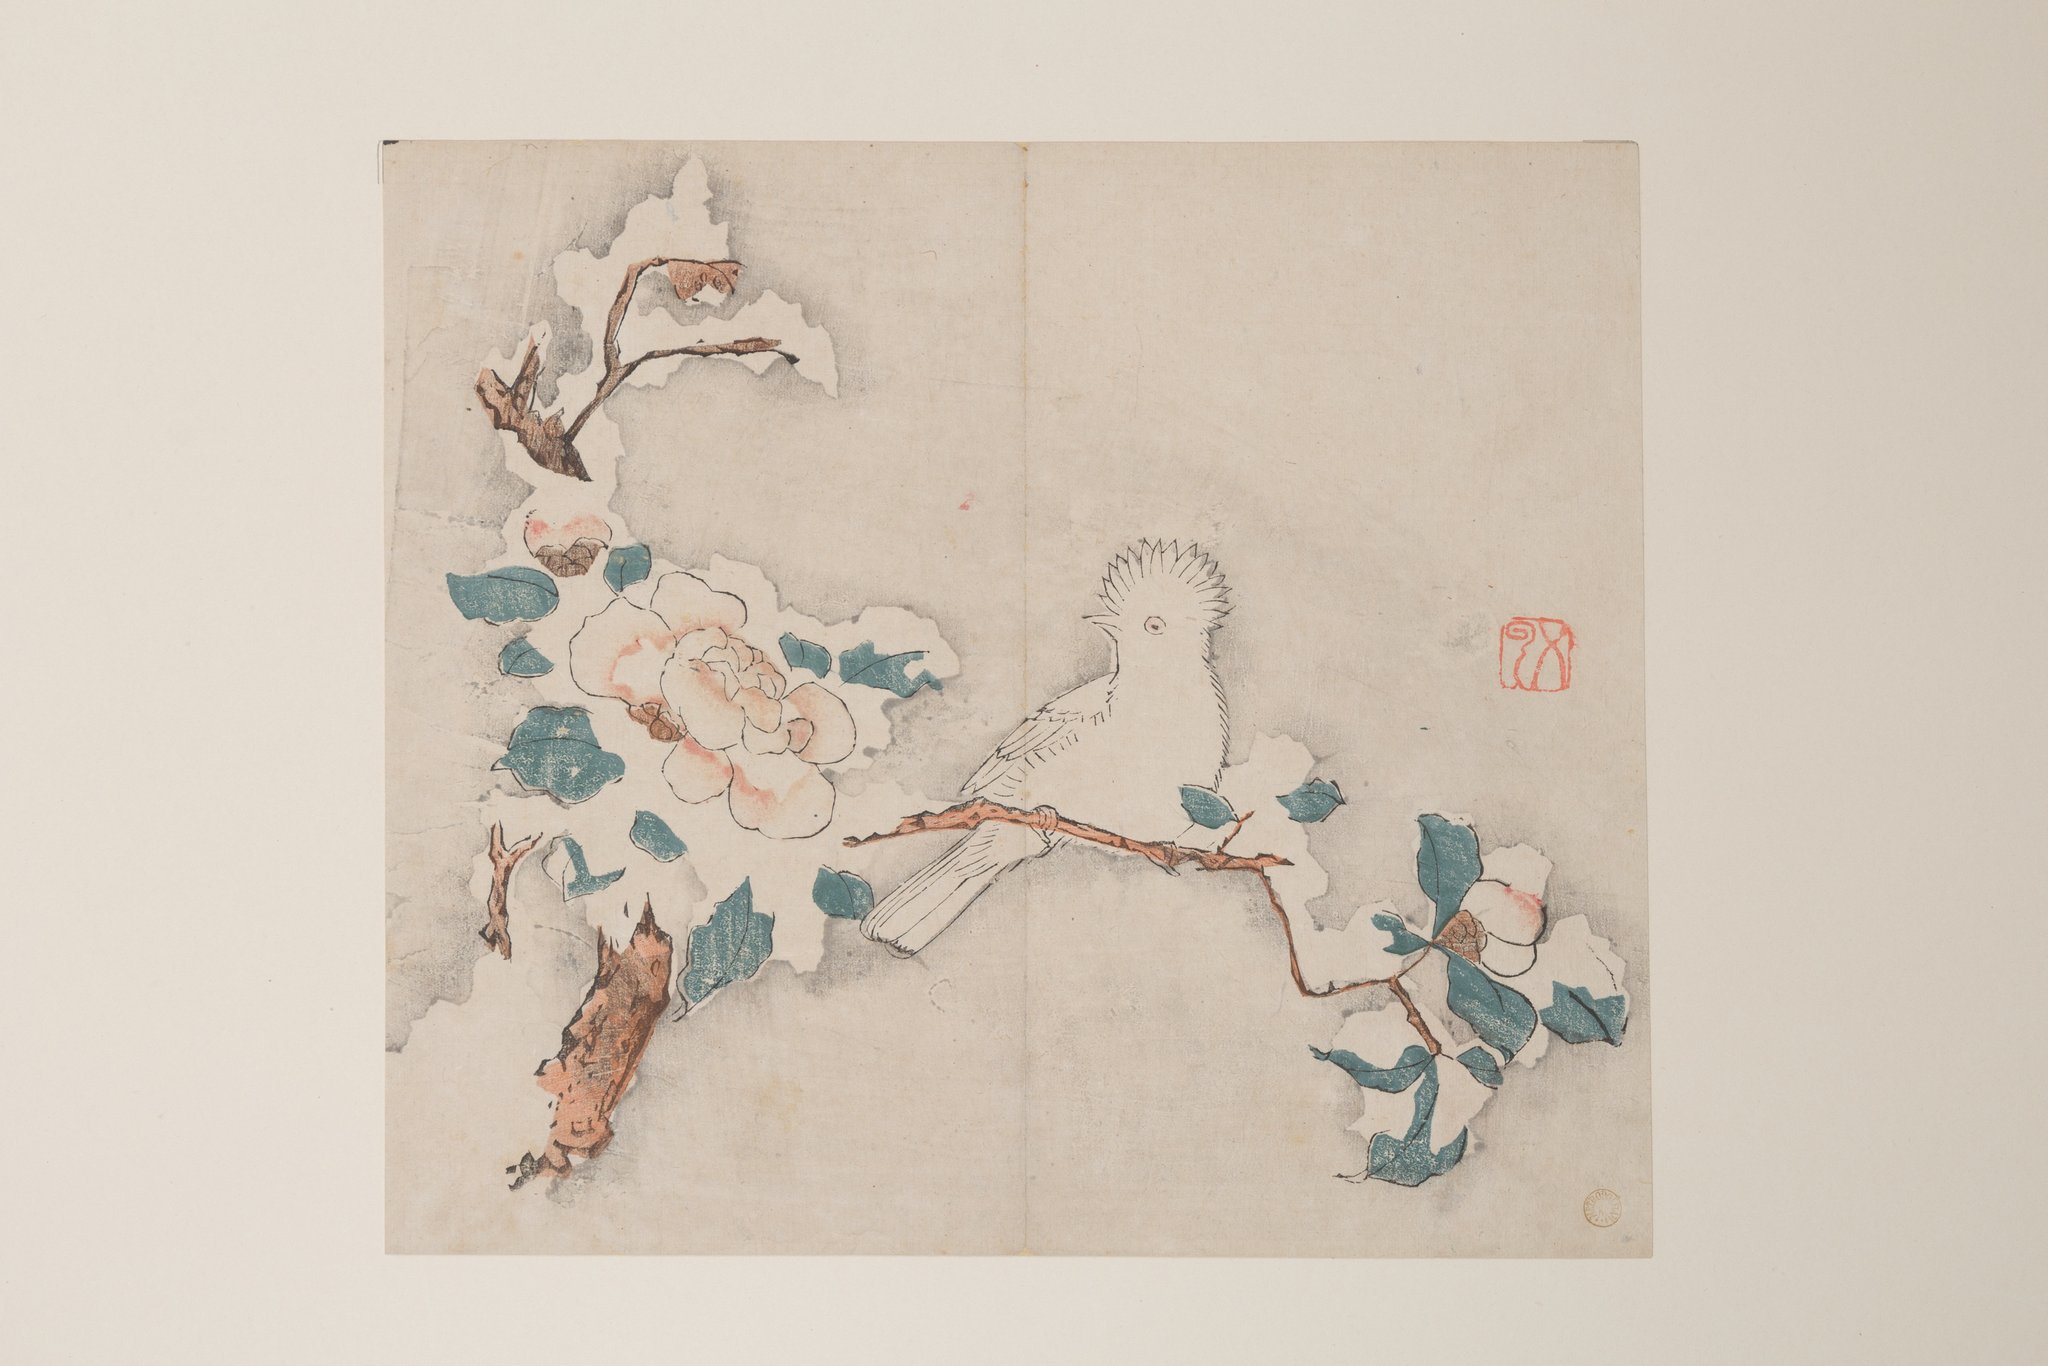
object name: print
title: Leaf from the Ten Bamboo Studio Manual of Painting and Calligraphy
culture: chinese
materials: ink, paper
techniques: printing